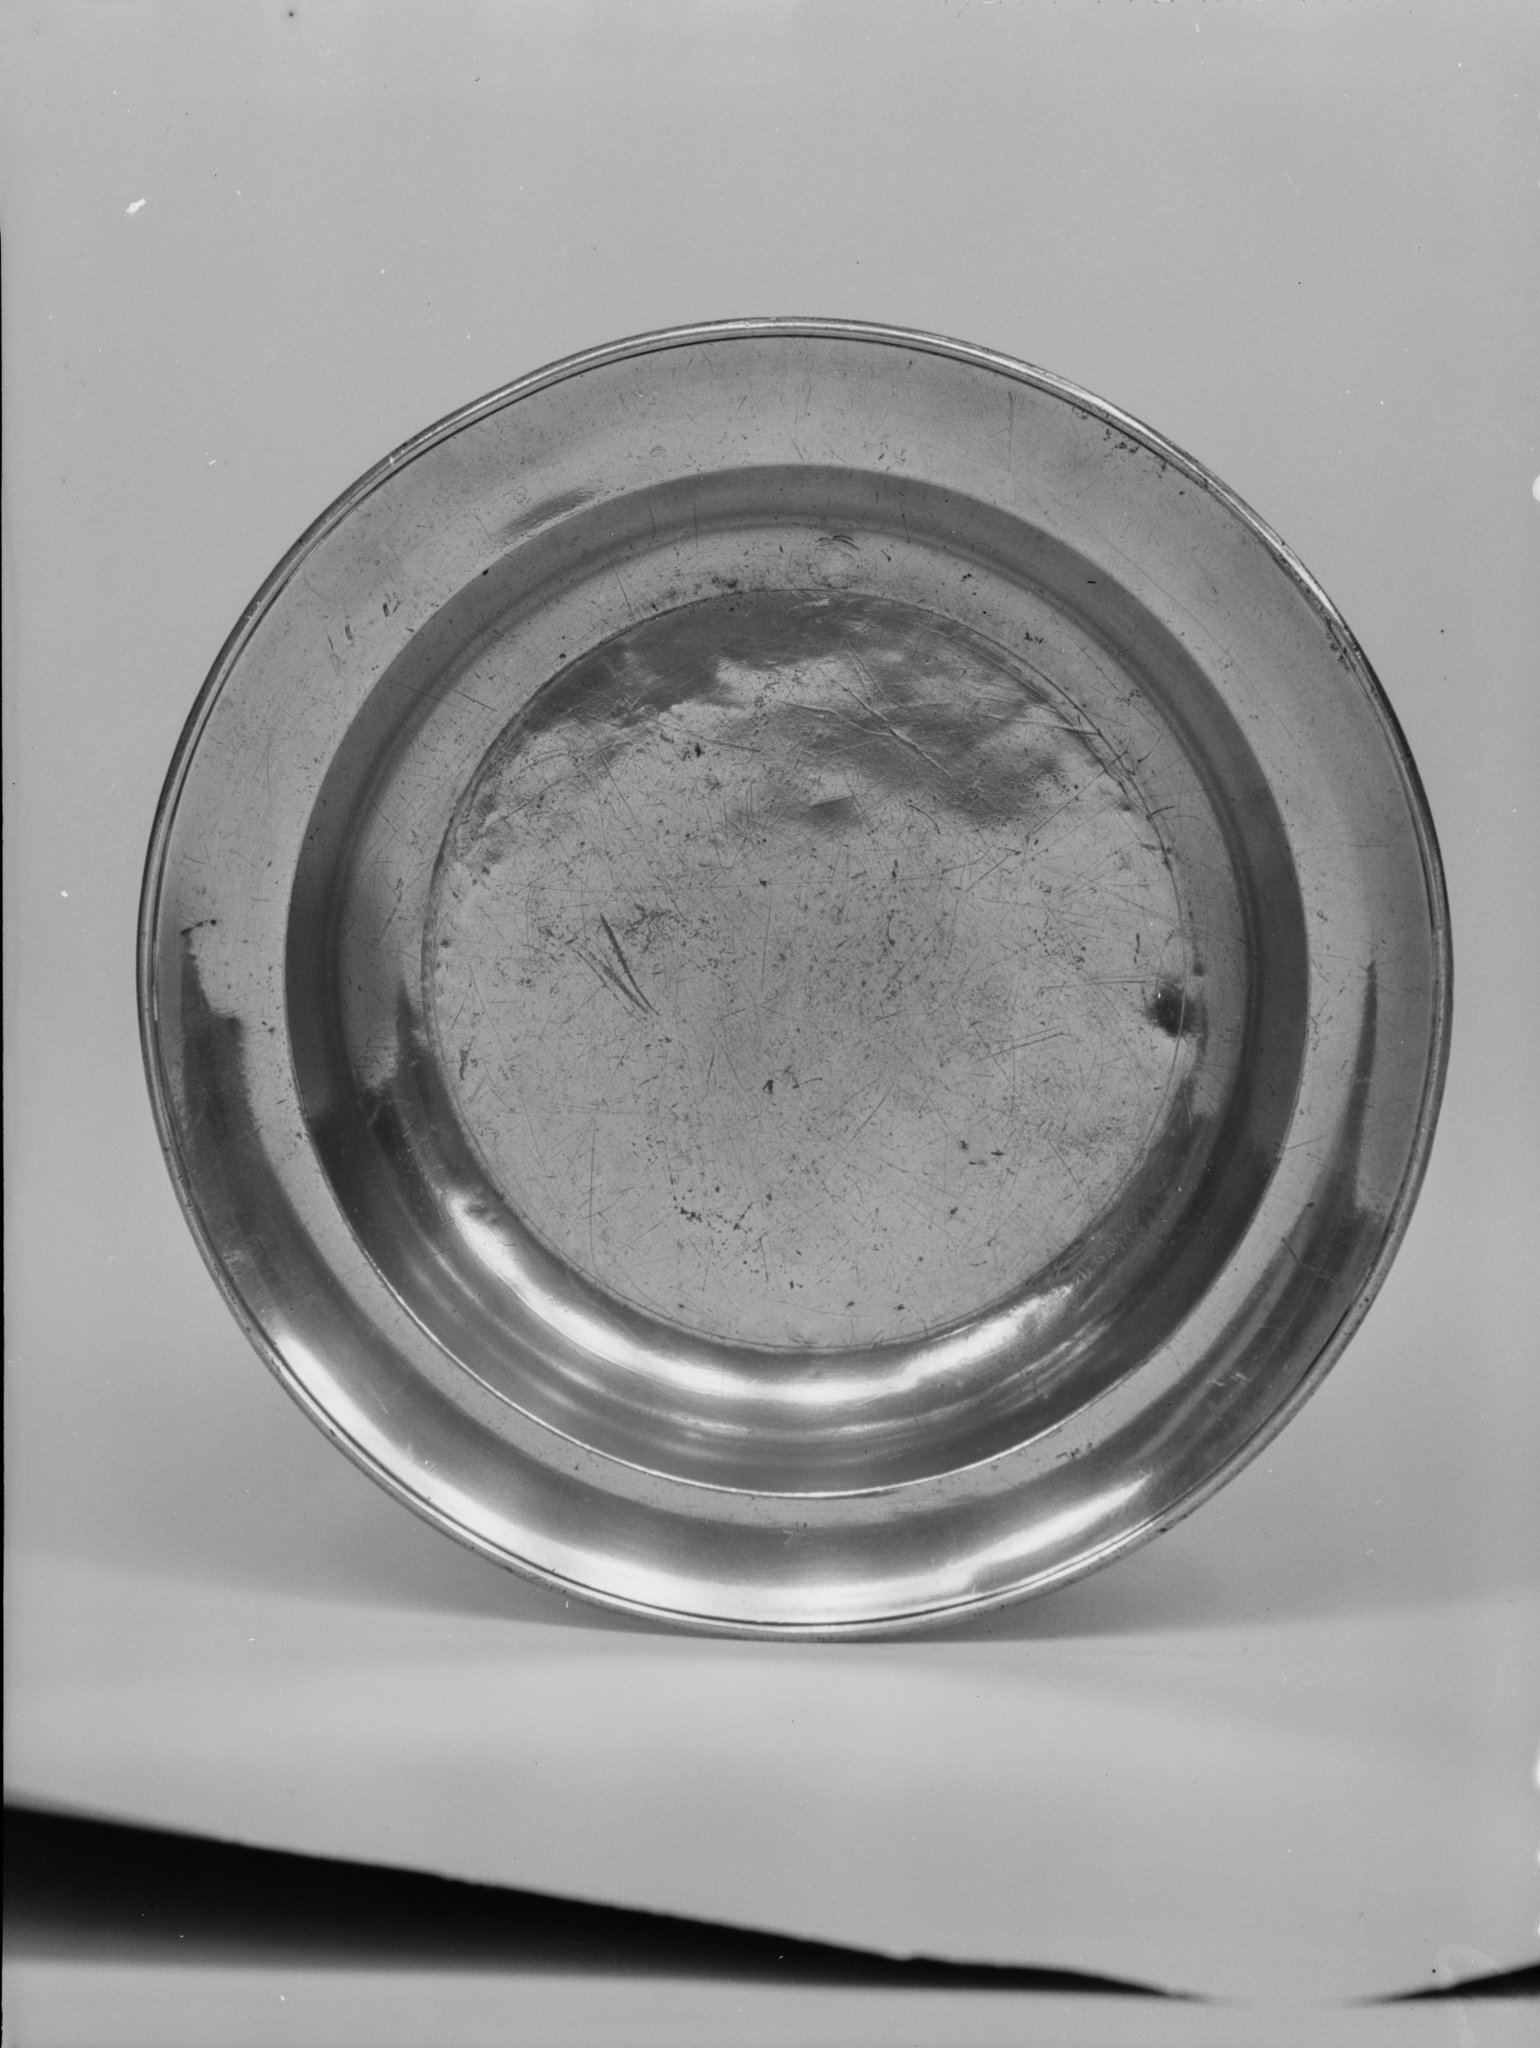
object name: dish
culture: american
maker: daniel curtiss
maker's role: maker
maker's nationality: american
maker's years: 1799-1872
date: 1822-1840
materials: pewter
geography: united states